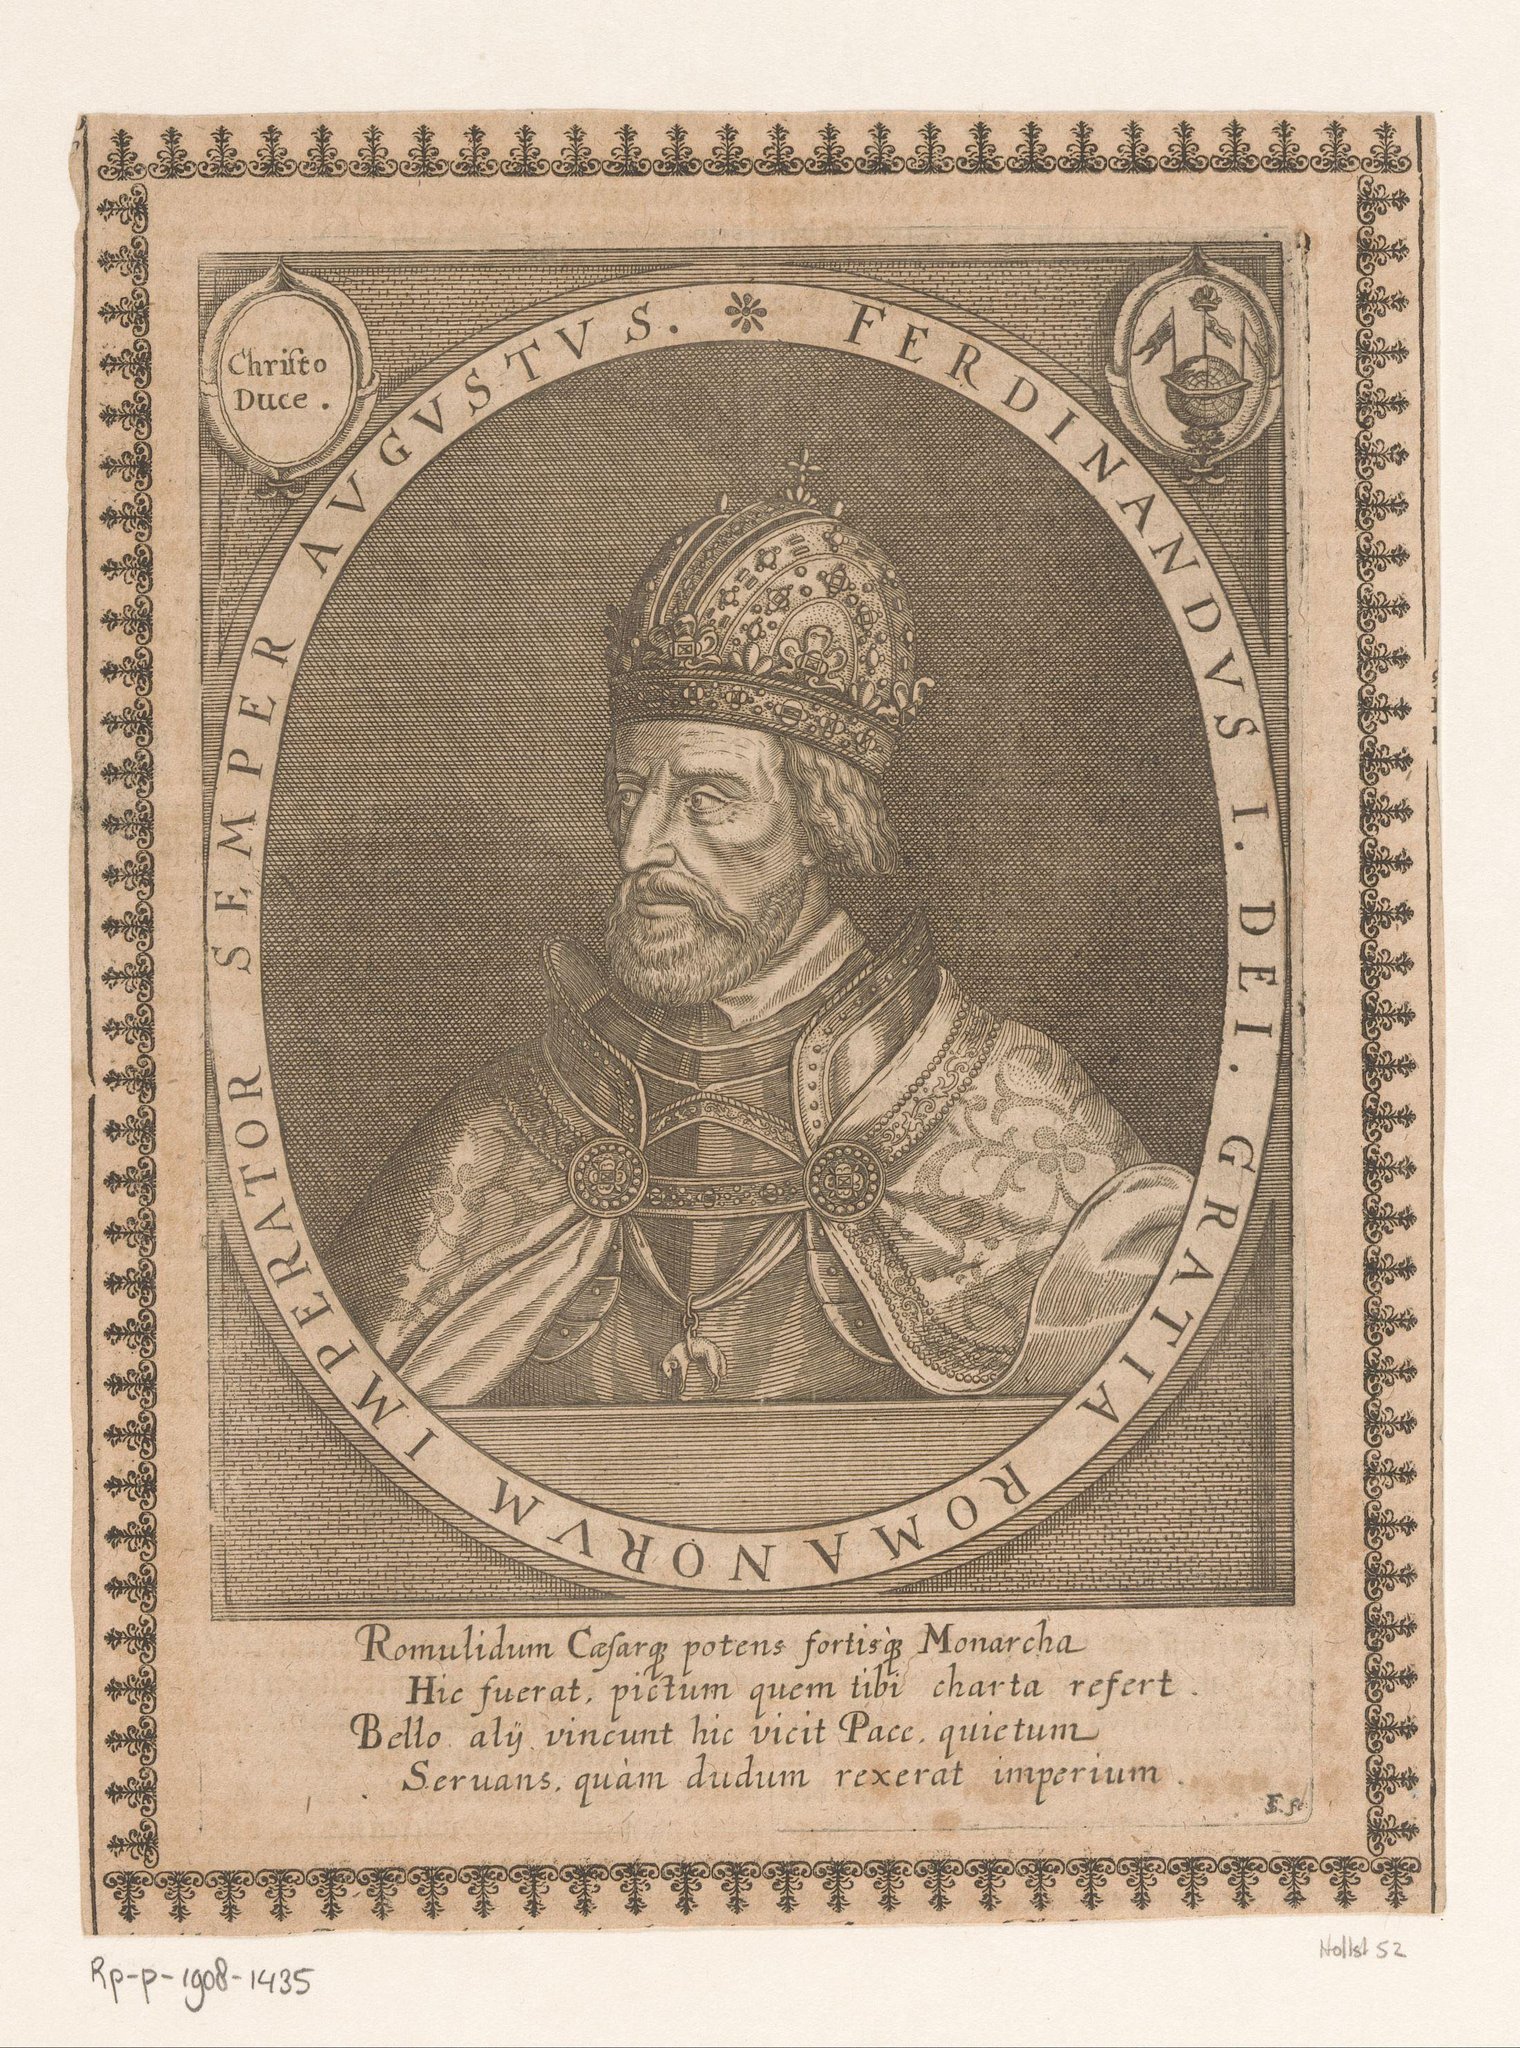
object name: book illustration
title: Portret van keizer Ferdinand I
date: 1641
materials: paper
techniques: engraving, letterpress printing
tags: vienna, ferdinand i van habsburg (duits keizer), historical persons, emperor, knighthood order of the golden fleece - insignia of a knighthood order, e.g.: badge, chain (with name of order), abstract ideas and concepts (+ emblematical representation of concept)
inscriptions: collector's mark: Lugt 2228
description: Prent uit: Helvicus, Nicolaus. Theatrum Historiae universalis Catholico Protestantium (...). Frankfurt am Main: Johann Gottfried Schönwetter, 1641.